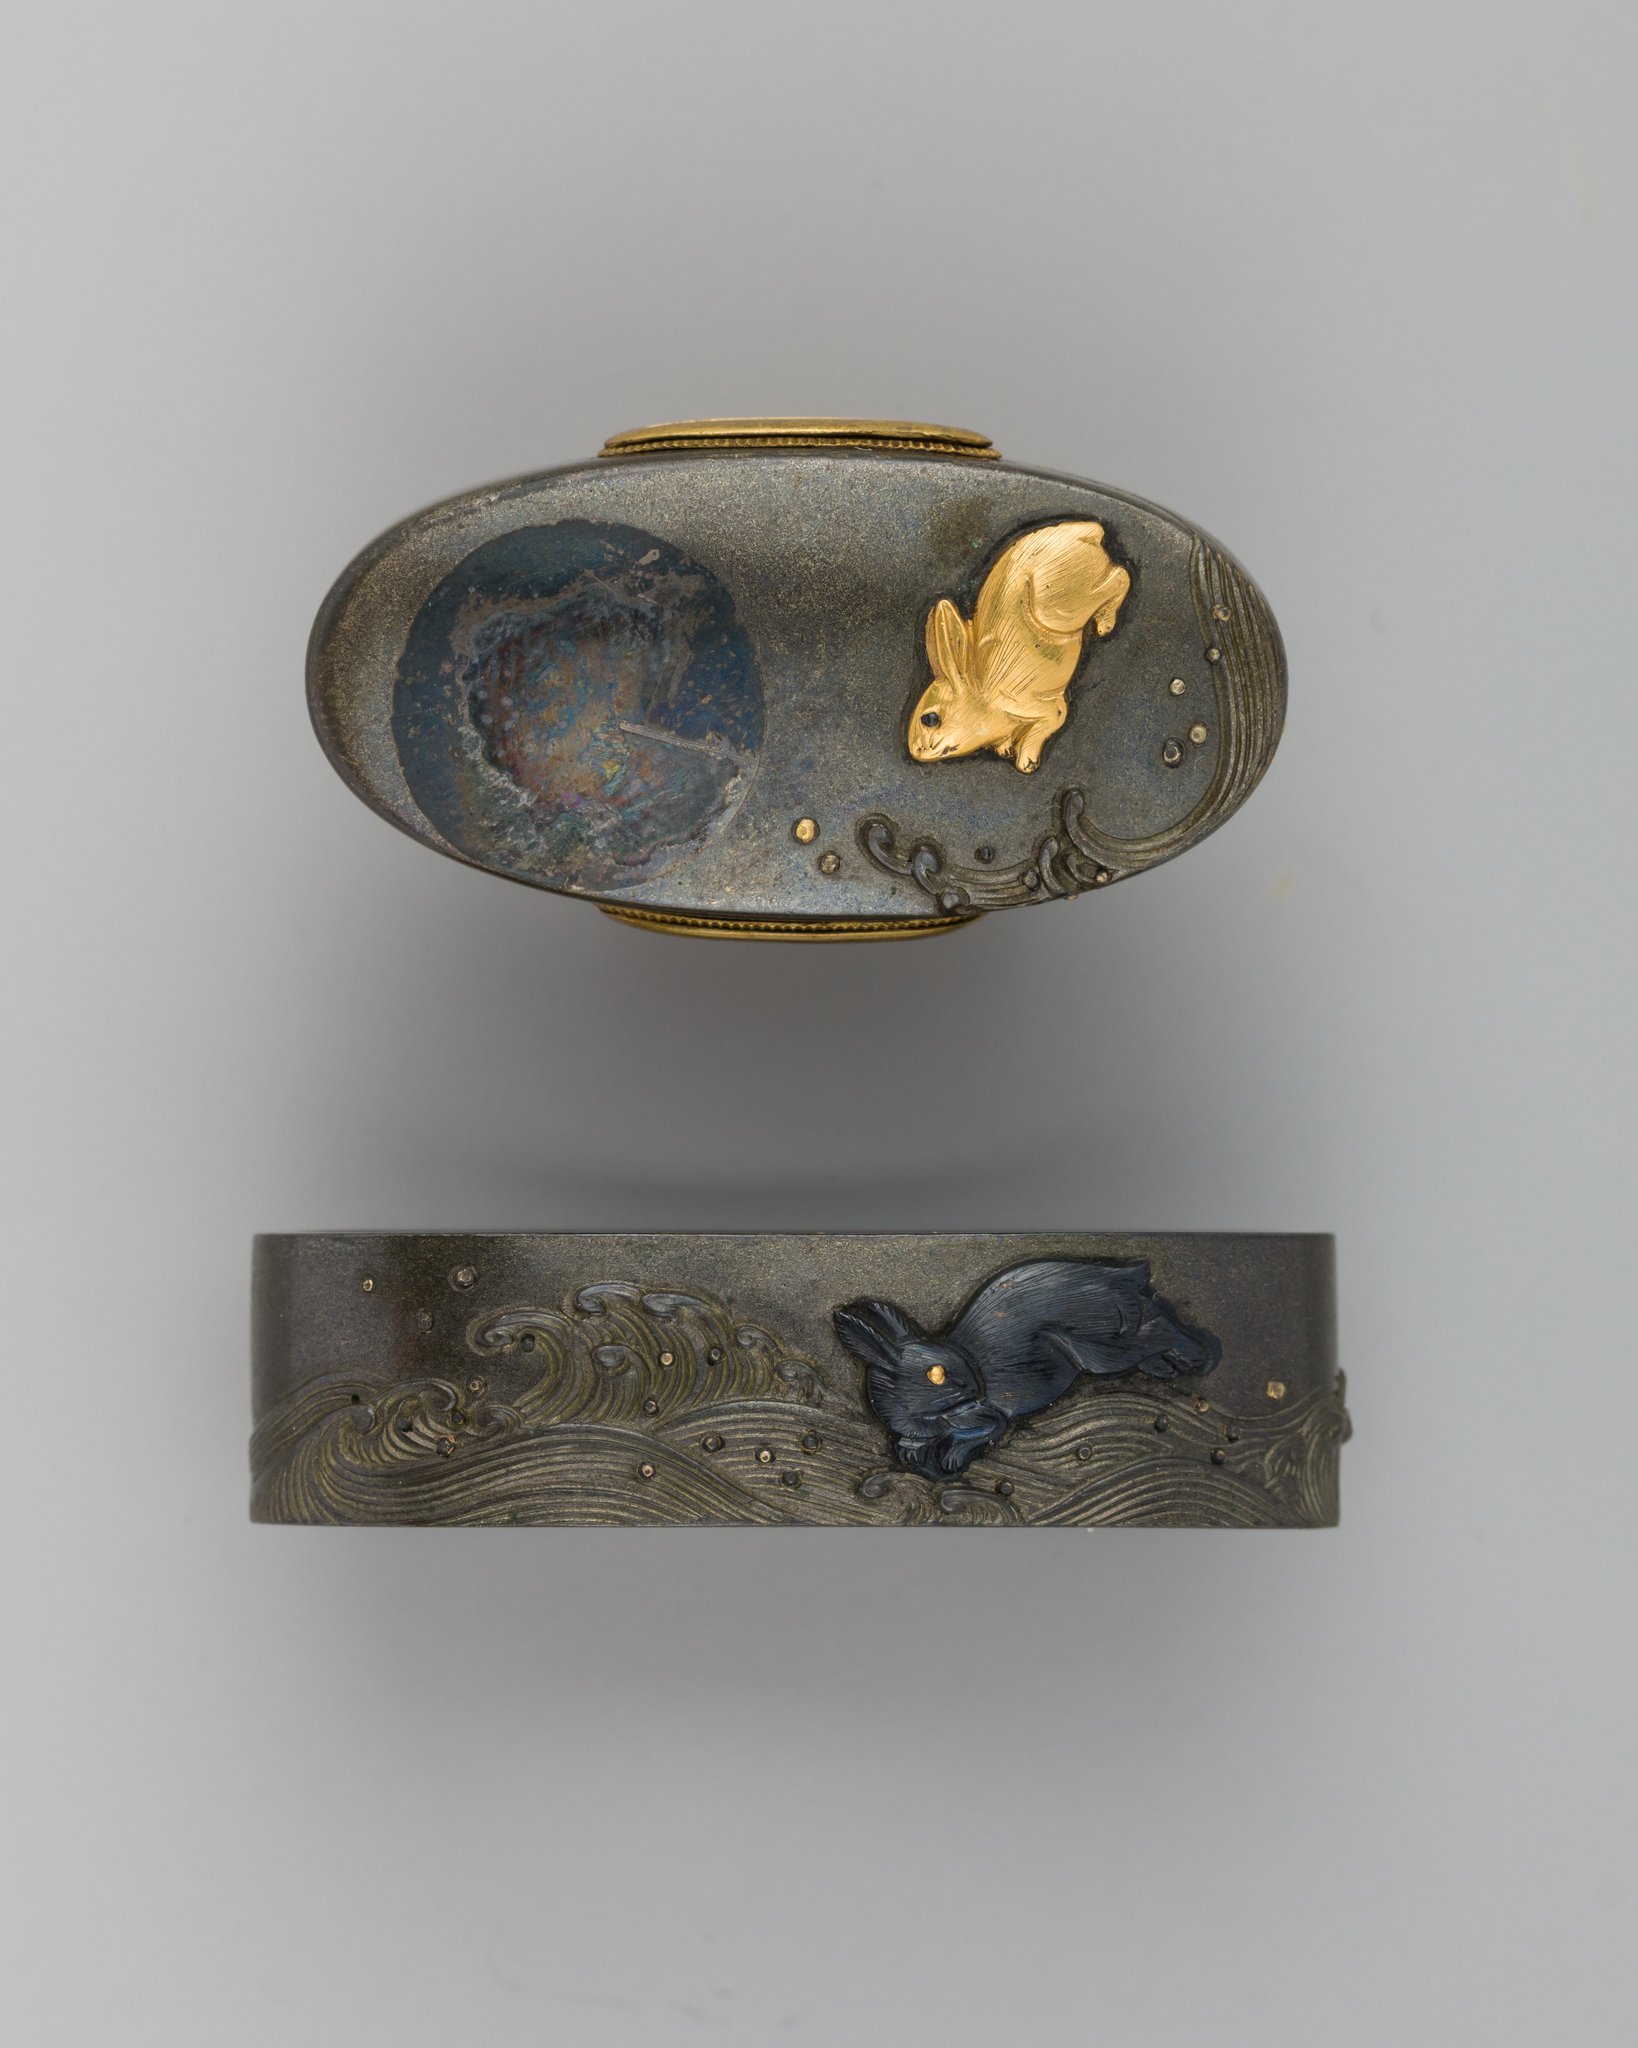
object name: sword hilt collar and pommel fuchigashira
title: Sword-Hilt Collar and Pommel (Fuchigashira)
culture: japanese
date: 1615-1868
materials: gold alloy, silver alloy, gold, silver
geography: japan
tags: rabbits